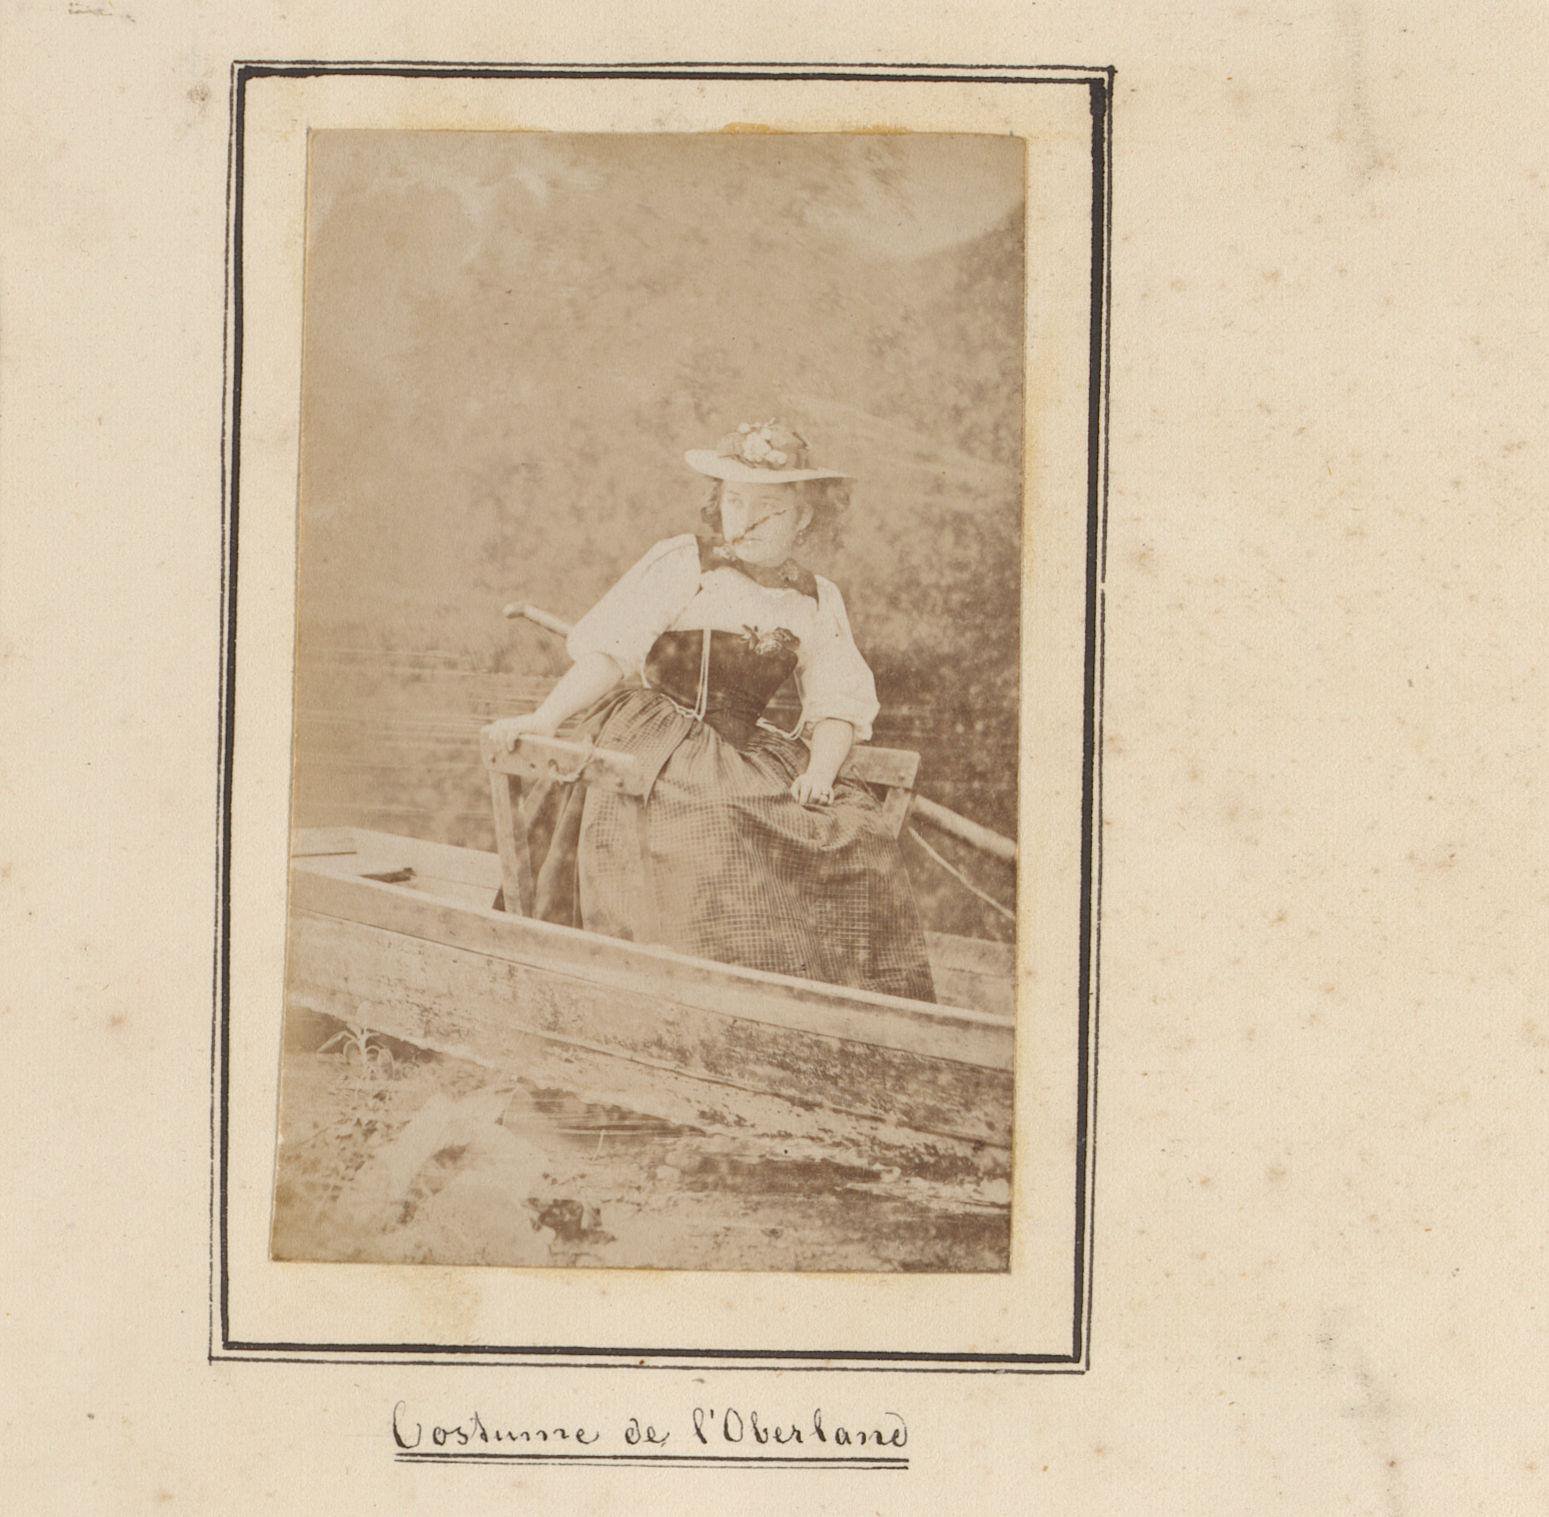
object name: photograph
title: Portret van een onbekende vrouw in klederdracht uit Berner Oberland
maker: Anonymous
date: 1870-1890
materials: paper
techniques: albumen print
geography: switzerland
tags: adult woman, anonymous historical person portrayed, folk costume, regional costume, switzerland